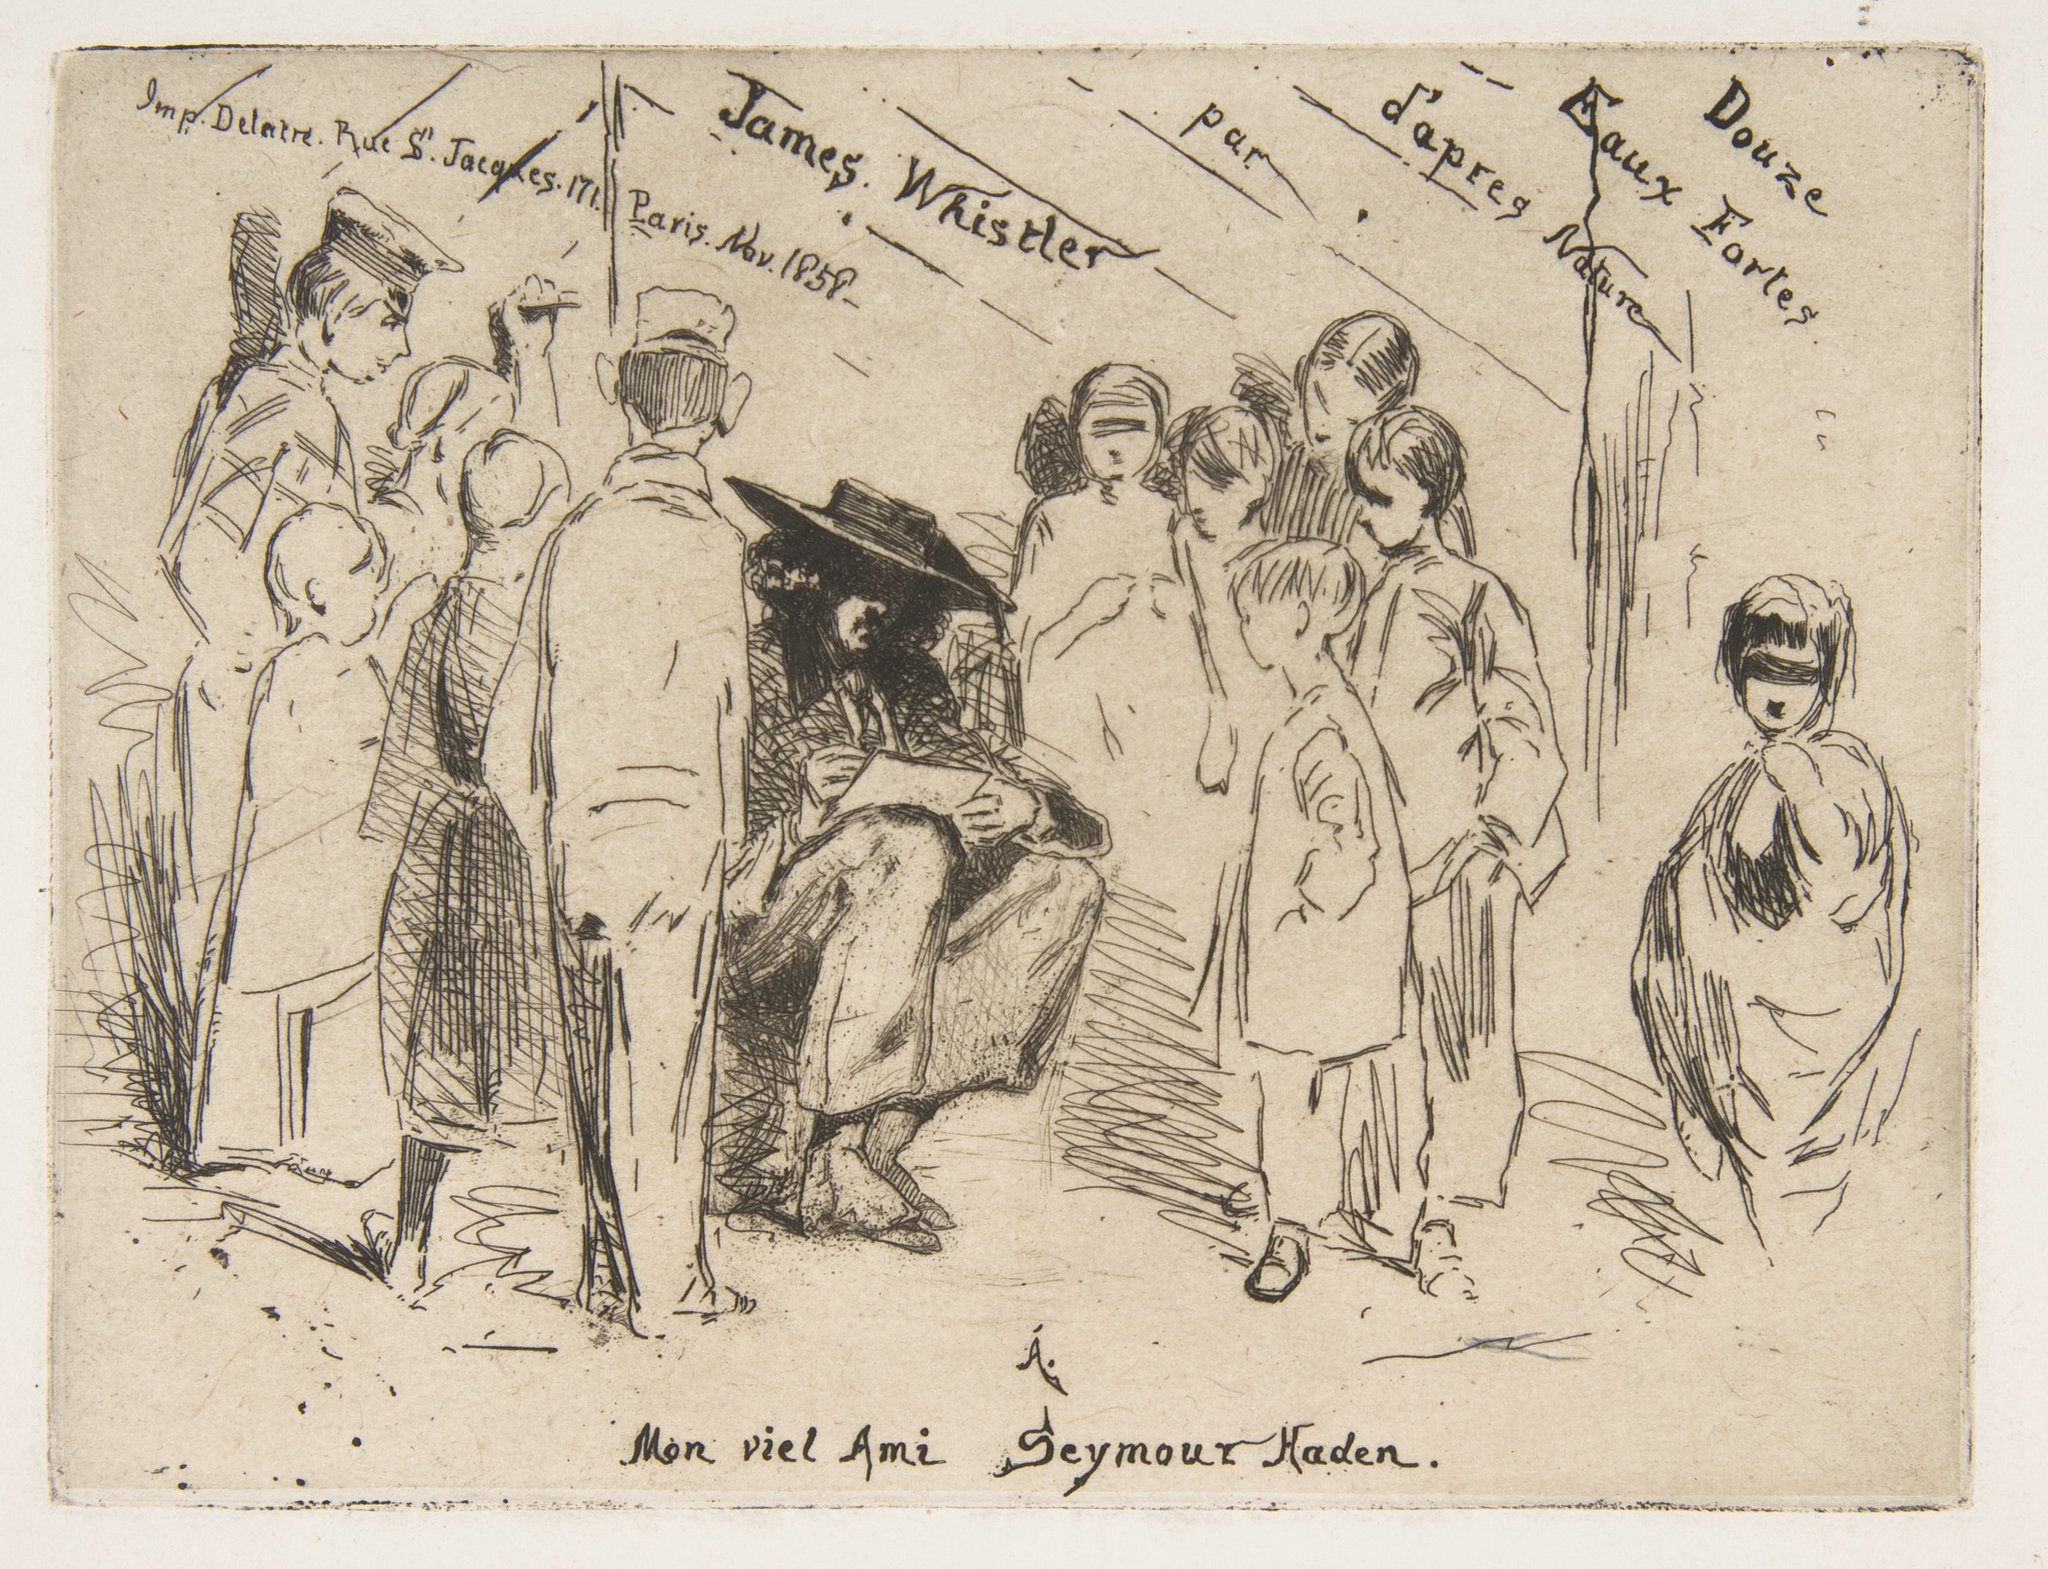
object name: print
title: Title to the French Set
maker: james mcneill whistler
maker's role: artist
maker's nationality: american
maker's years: 1834-1903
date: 1858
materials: chine, ink, paper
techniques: printmaking, etching, printing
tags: children,men